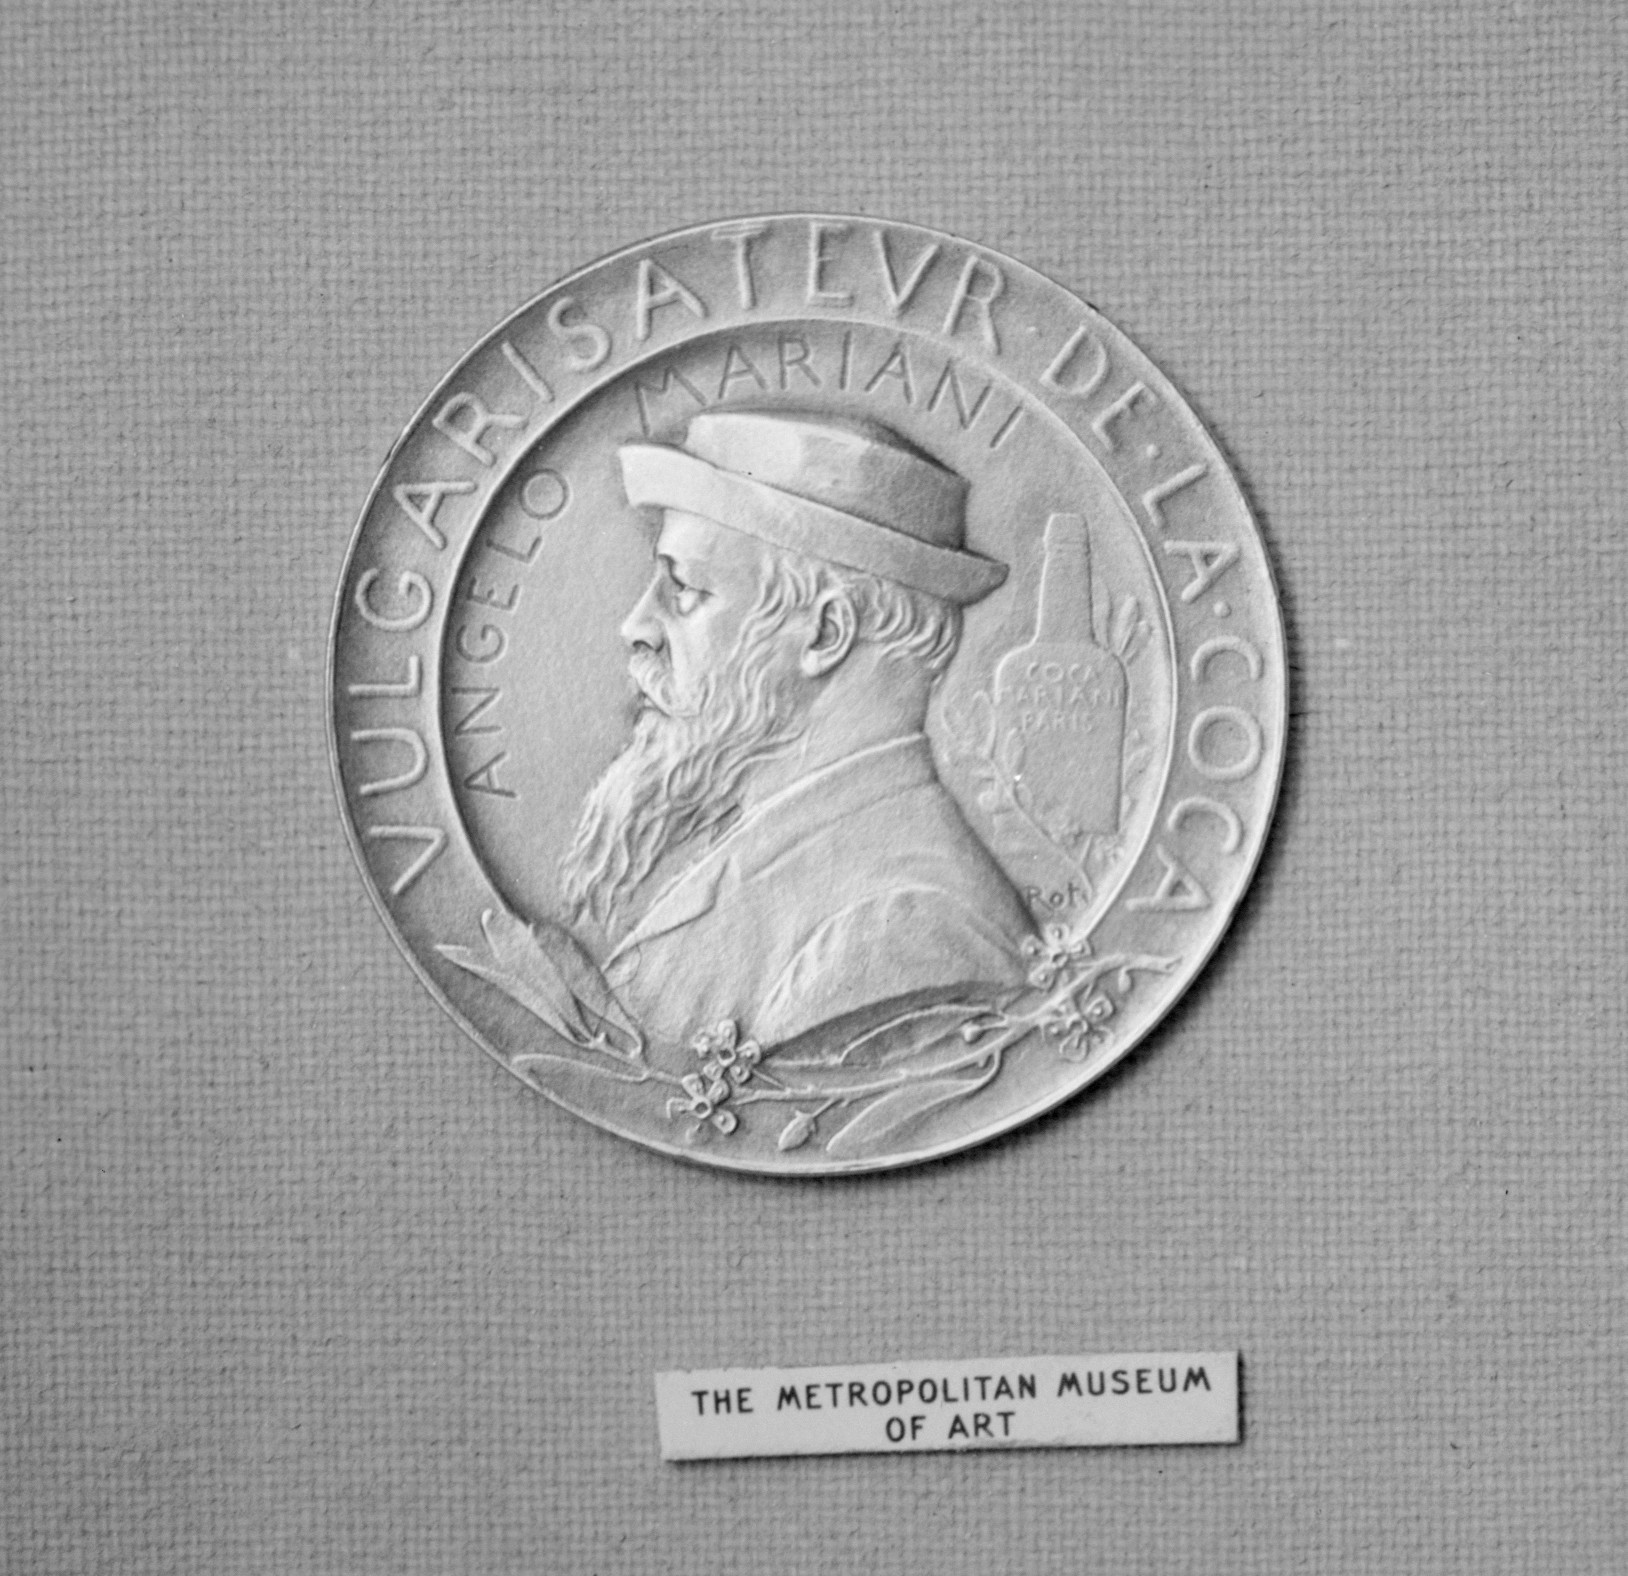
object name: jeton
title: M. Angelo Mariani, Proprietor of the Mariani Coca-Wine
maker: louis-oscar roty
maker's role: artist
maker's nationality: french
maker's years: 1846-1911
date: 1895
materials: silver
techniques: struck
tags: men,profiles